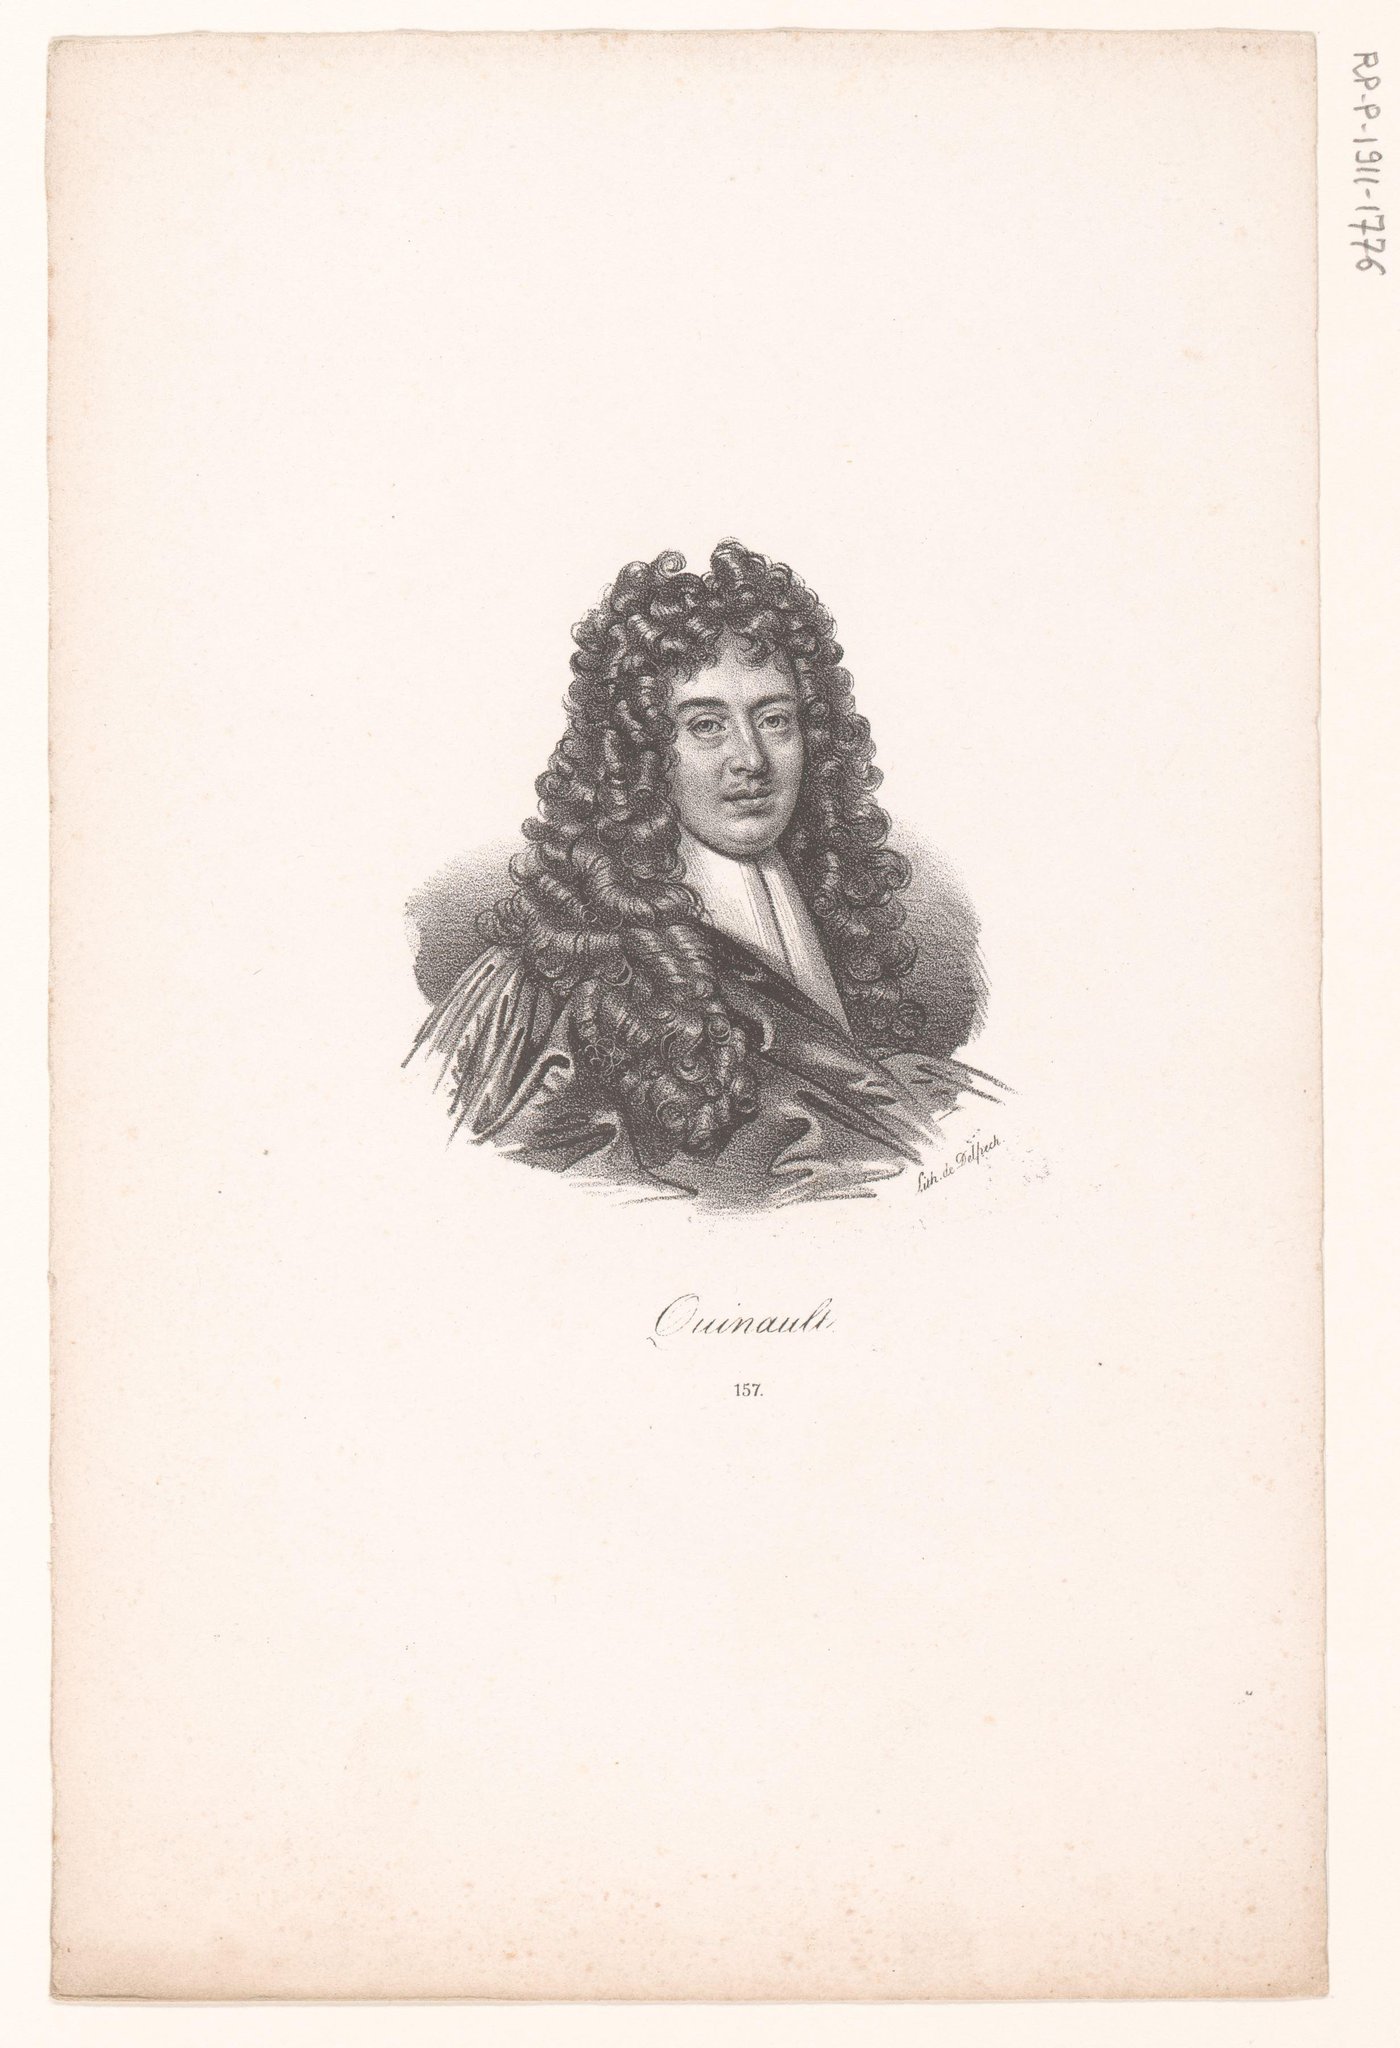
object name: print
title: Portret van Philippe Quinault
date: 1818-1842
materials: paper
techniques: lithograph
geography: paris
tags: paris, historical persons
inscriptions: collector's mark: Lugt 2228a